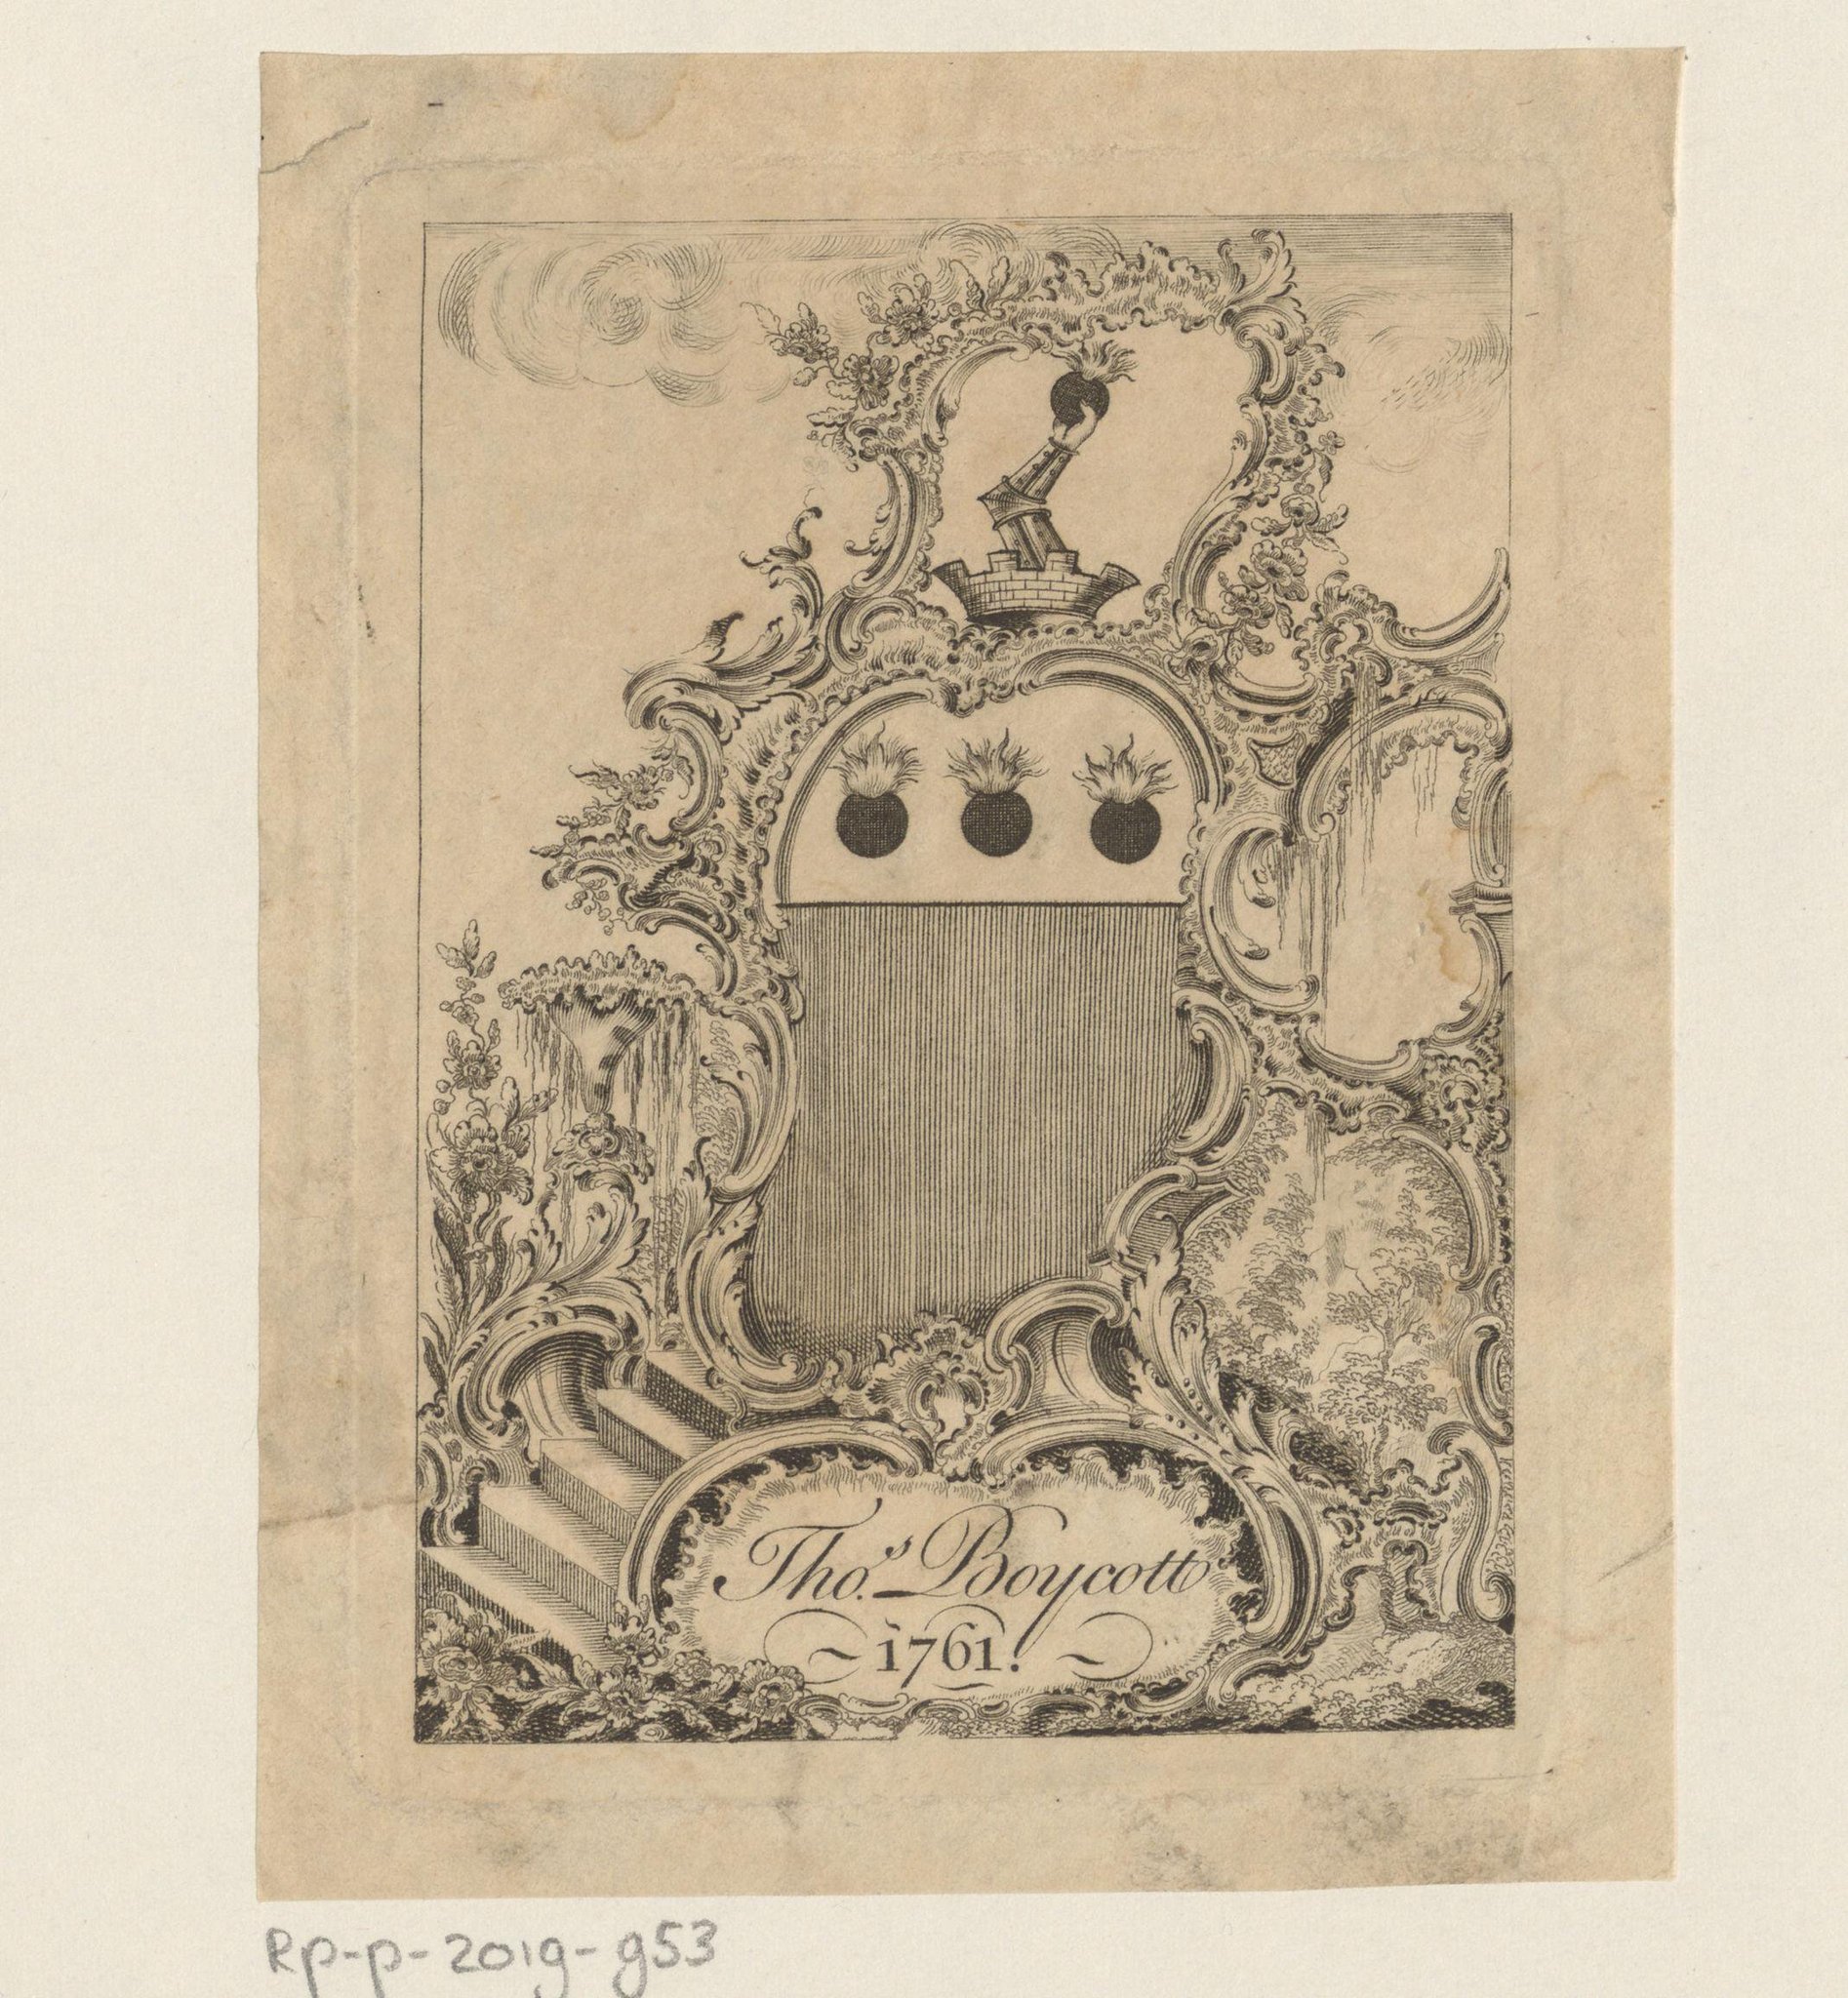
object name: bookplate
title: Ex libris van Tho. Boycott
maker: Anonymous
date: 1761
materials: paper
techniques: engraving, etching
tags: armorial bearing, heraldry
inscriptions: date